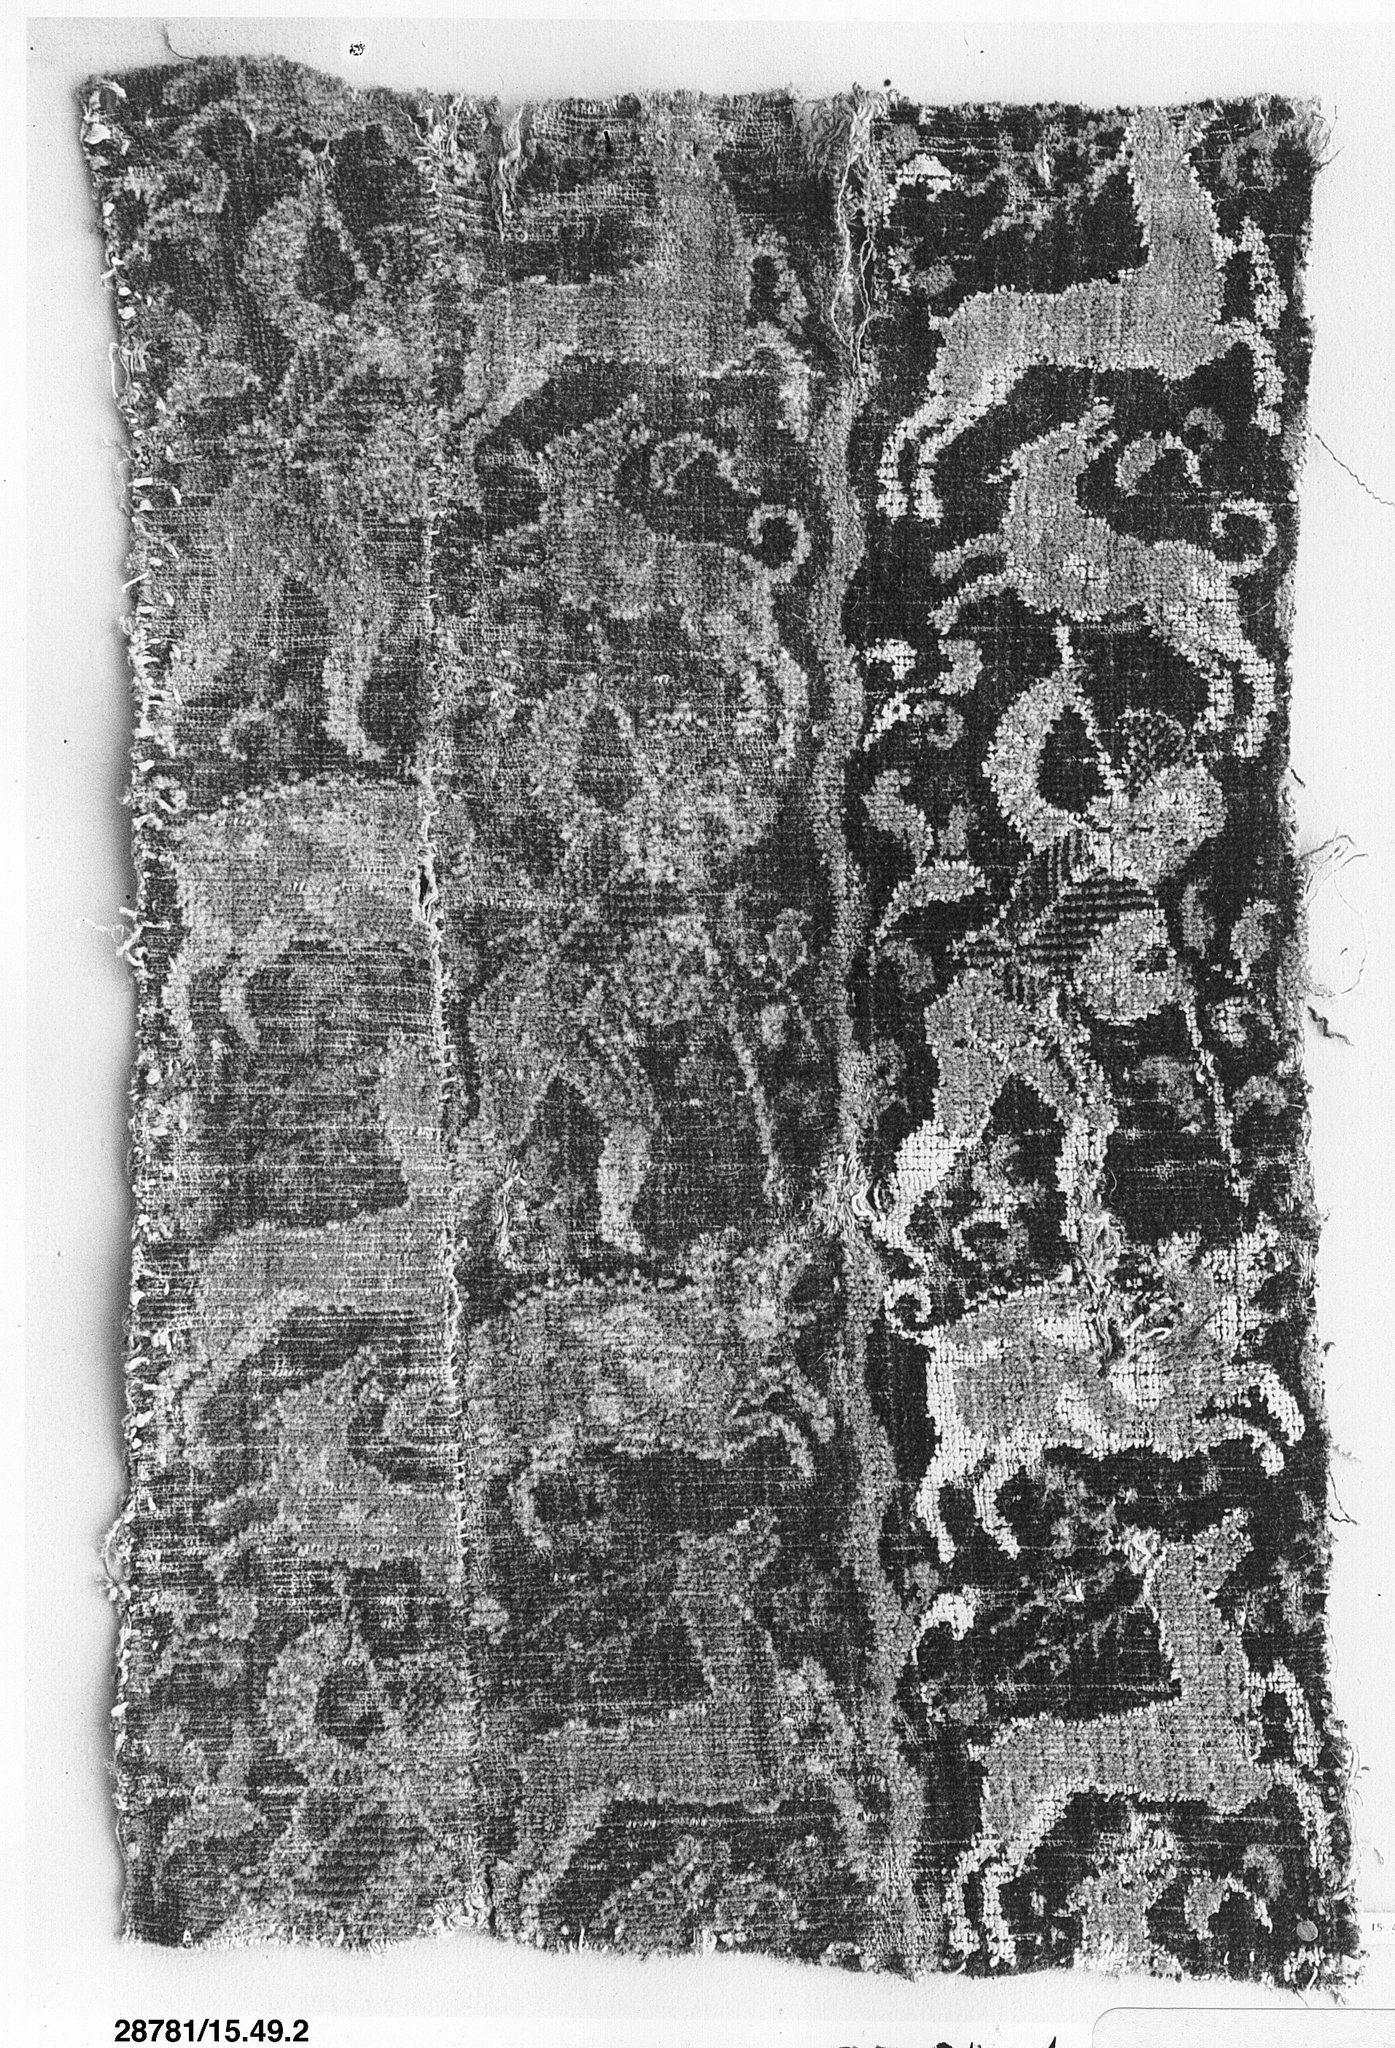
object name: fragment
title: Carpet fragment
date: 1501-1600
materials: linen, wool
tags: human figures,animals